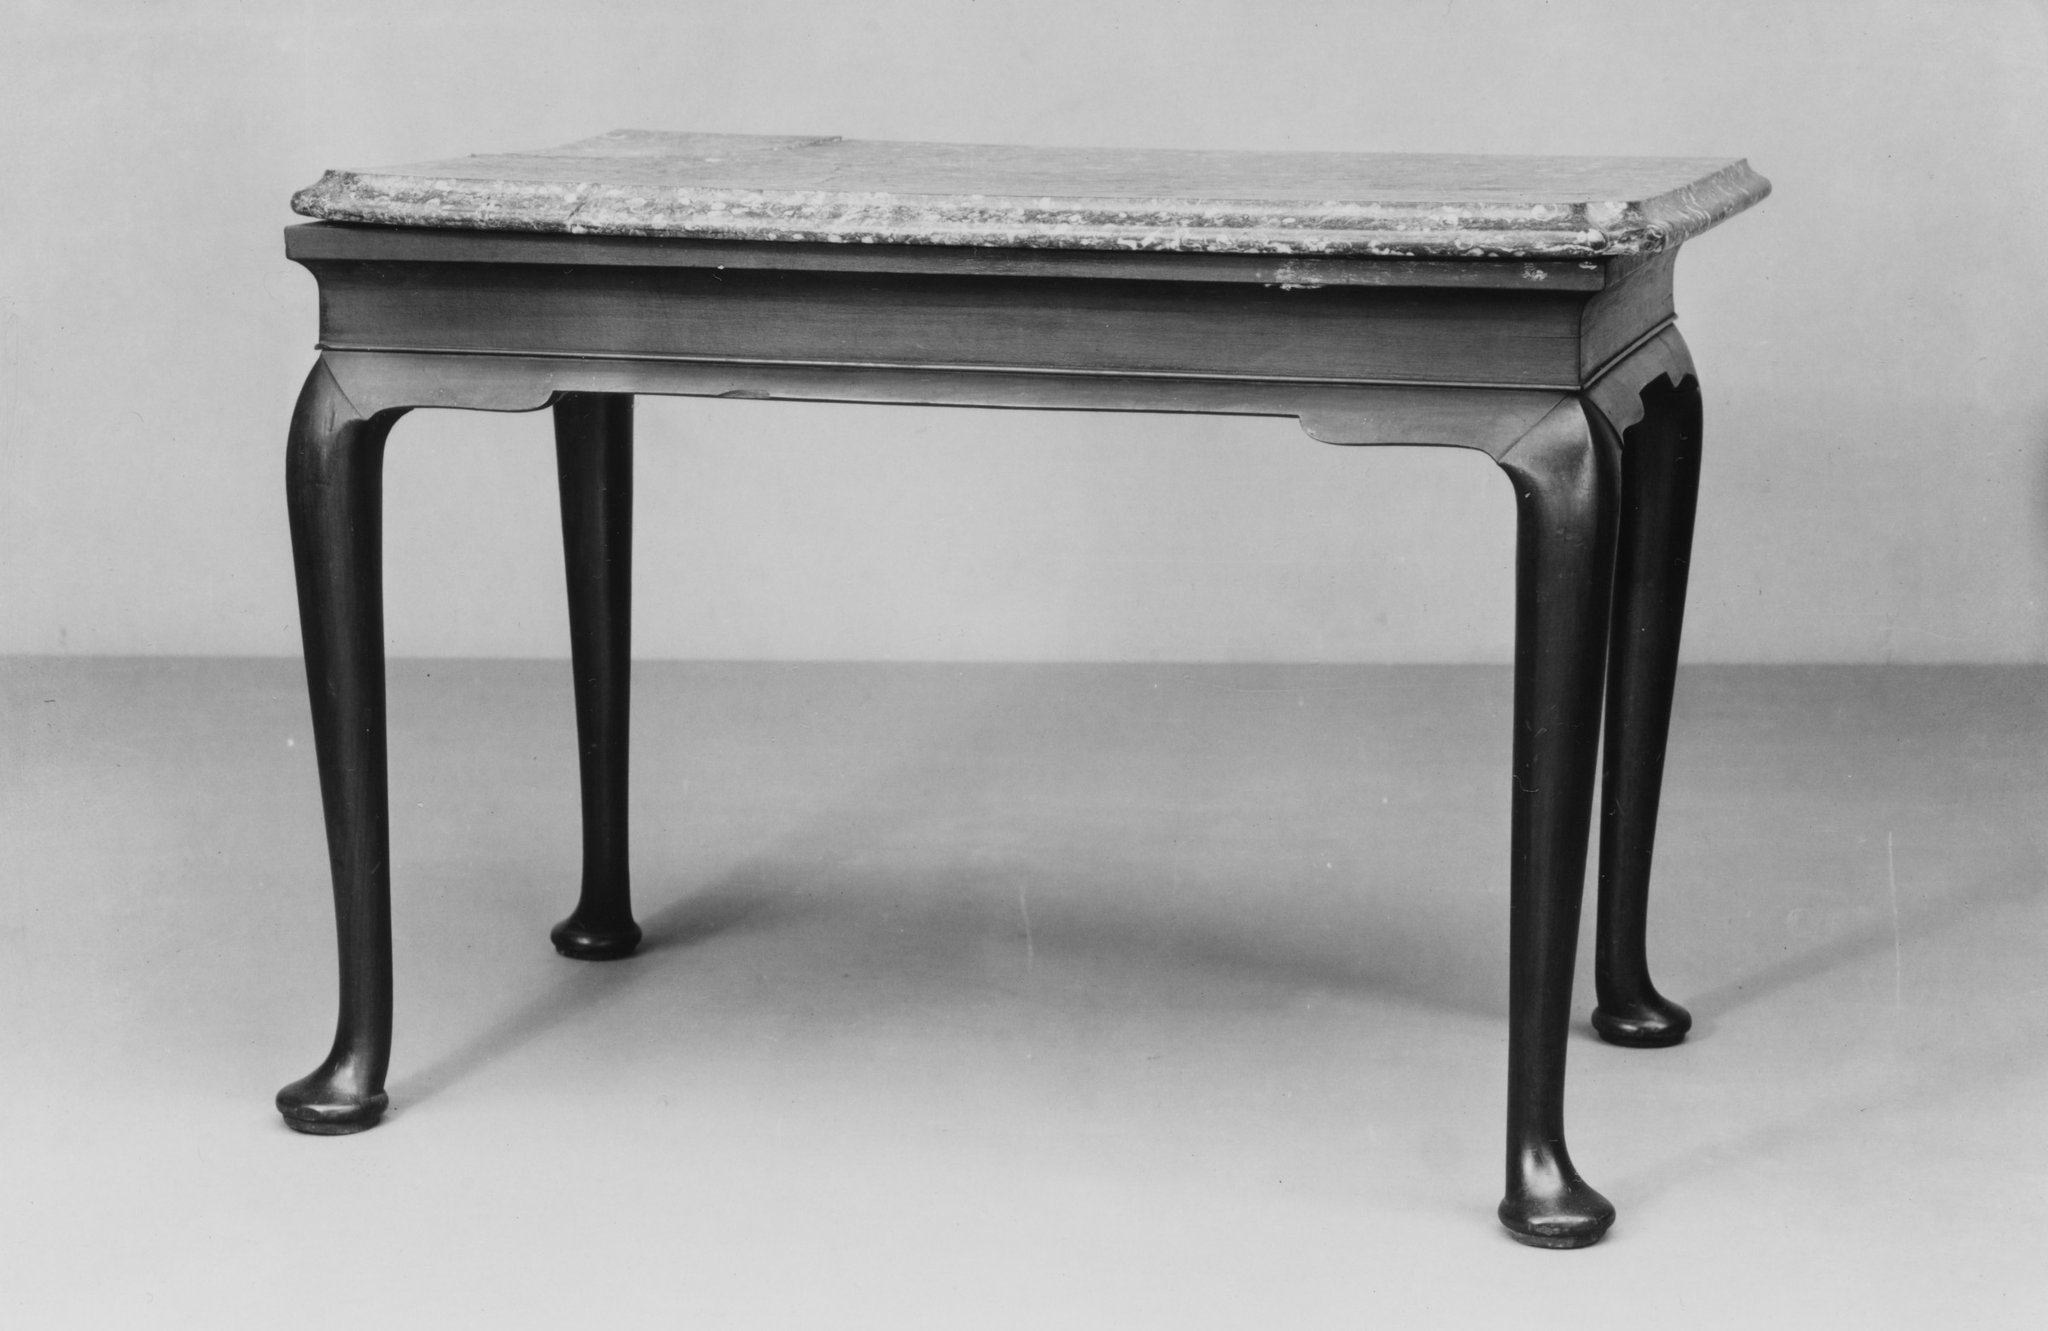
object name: pier table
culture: european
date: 1740-1770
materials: wood, marble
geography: united states